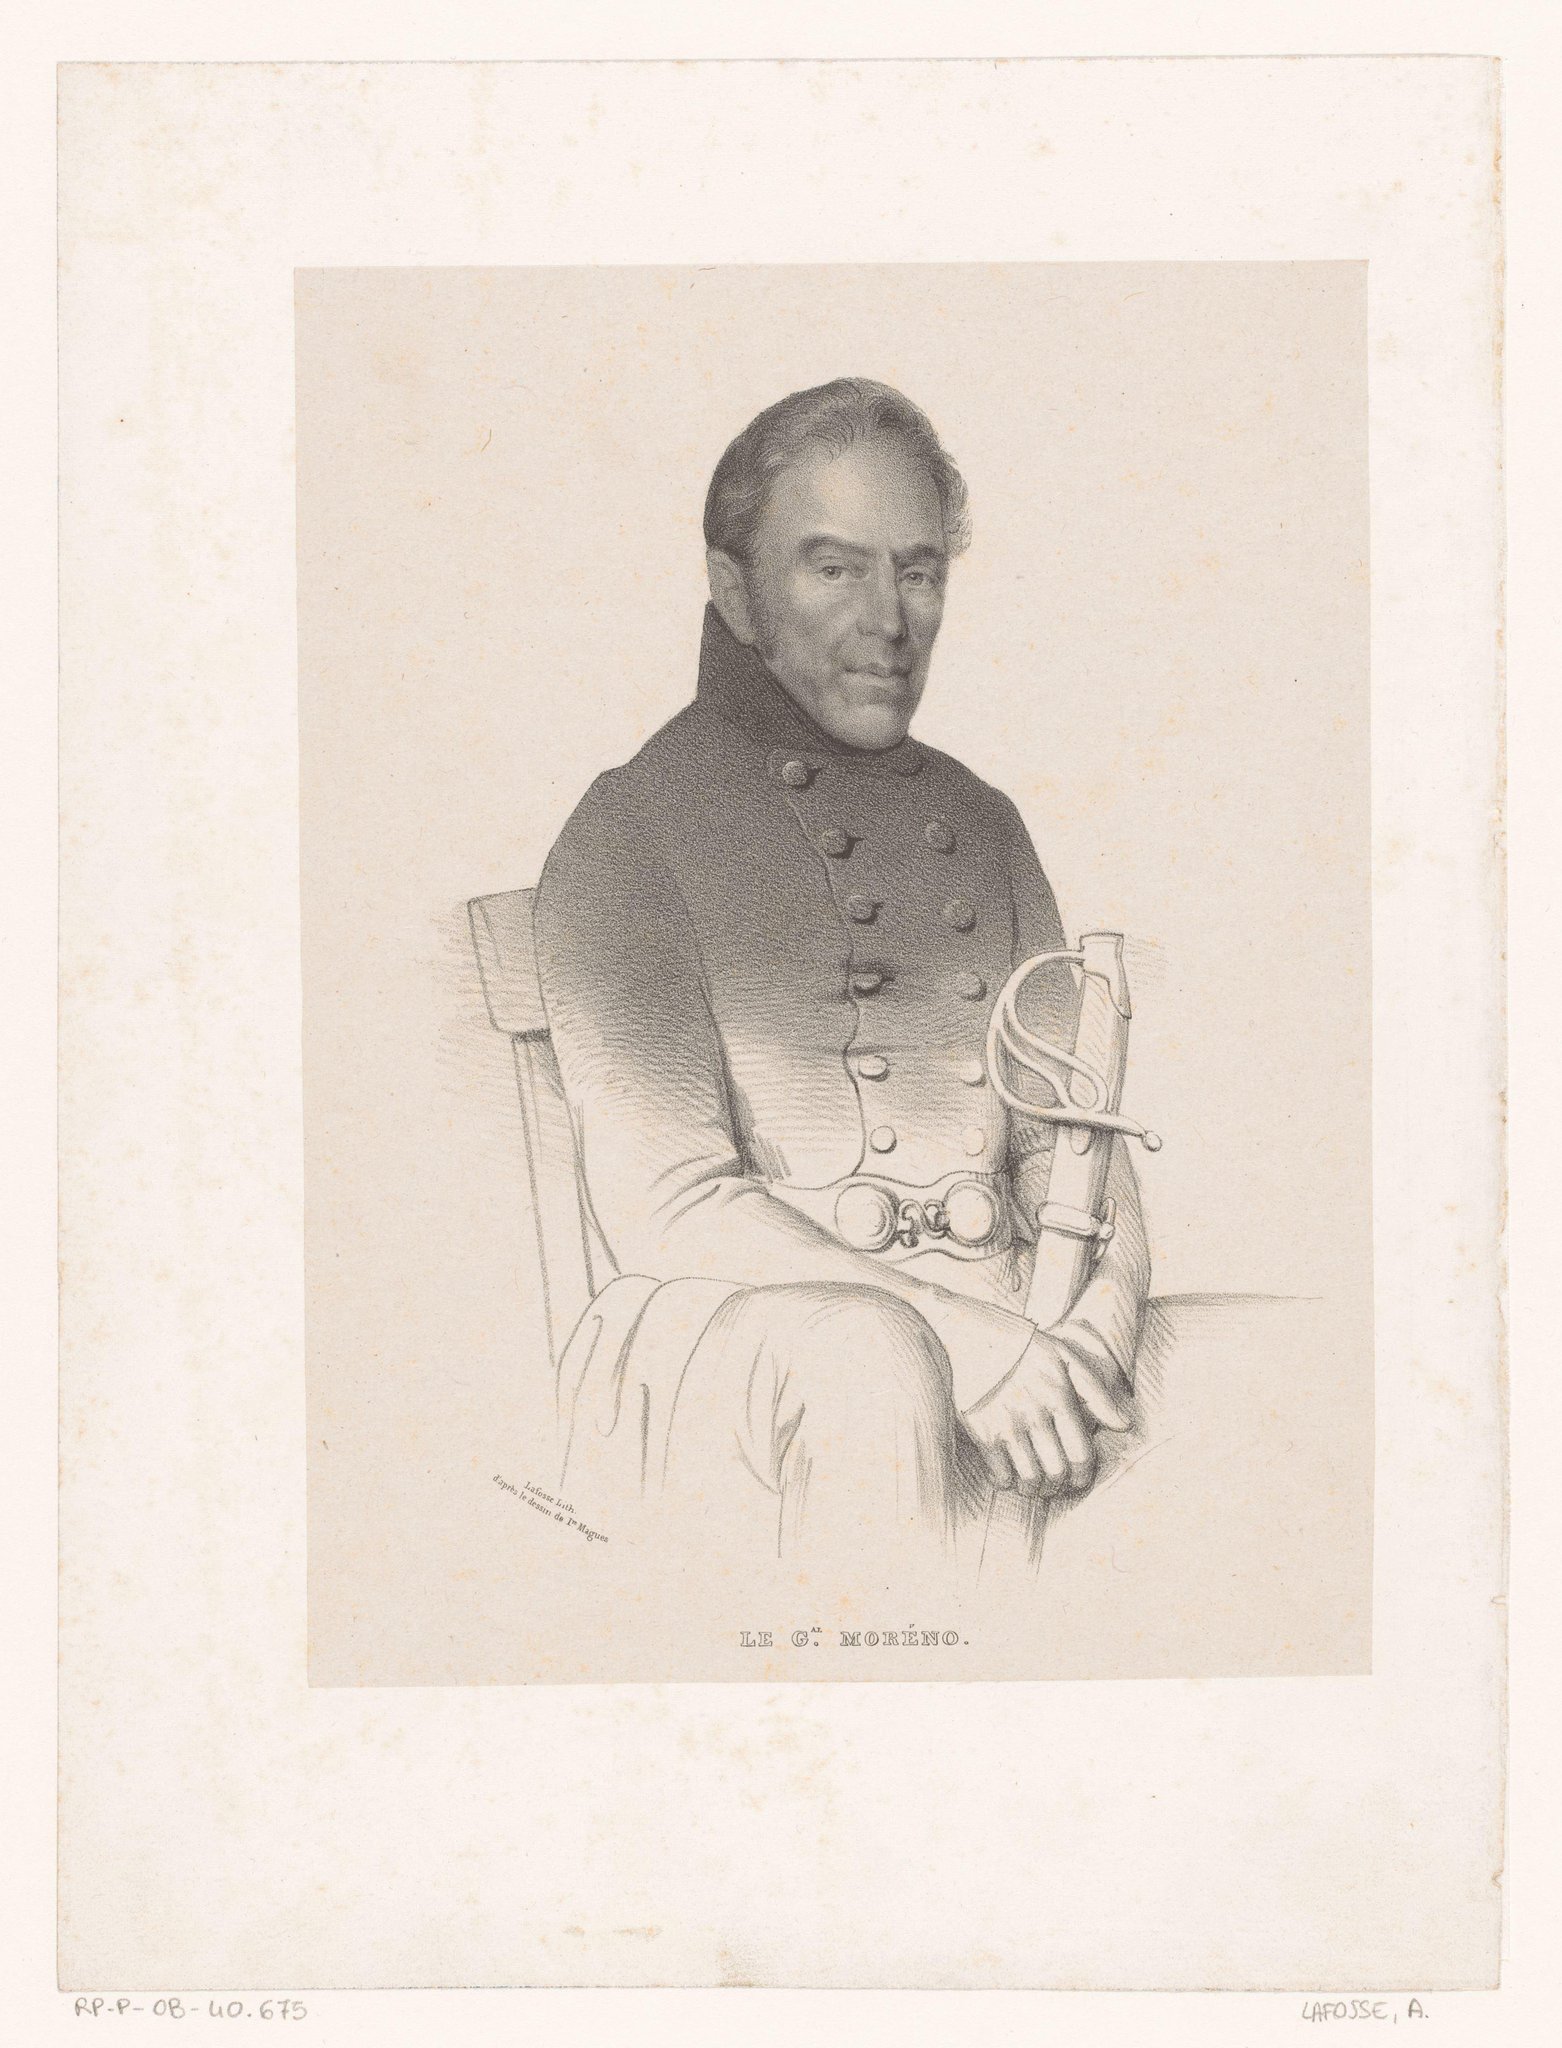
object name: print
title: Portret van Gabriel García Moreno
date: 1850-1875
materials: paper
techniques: lithograph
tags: politician, historical persons